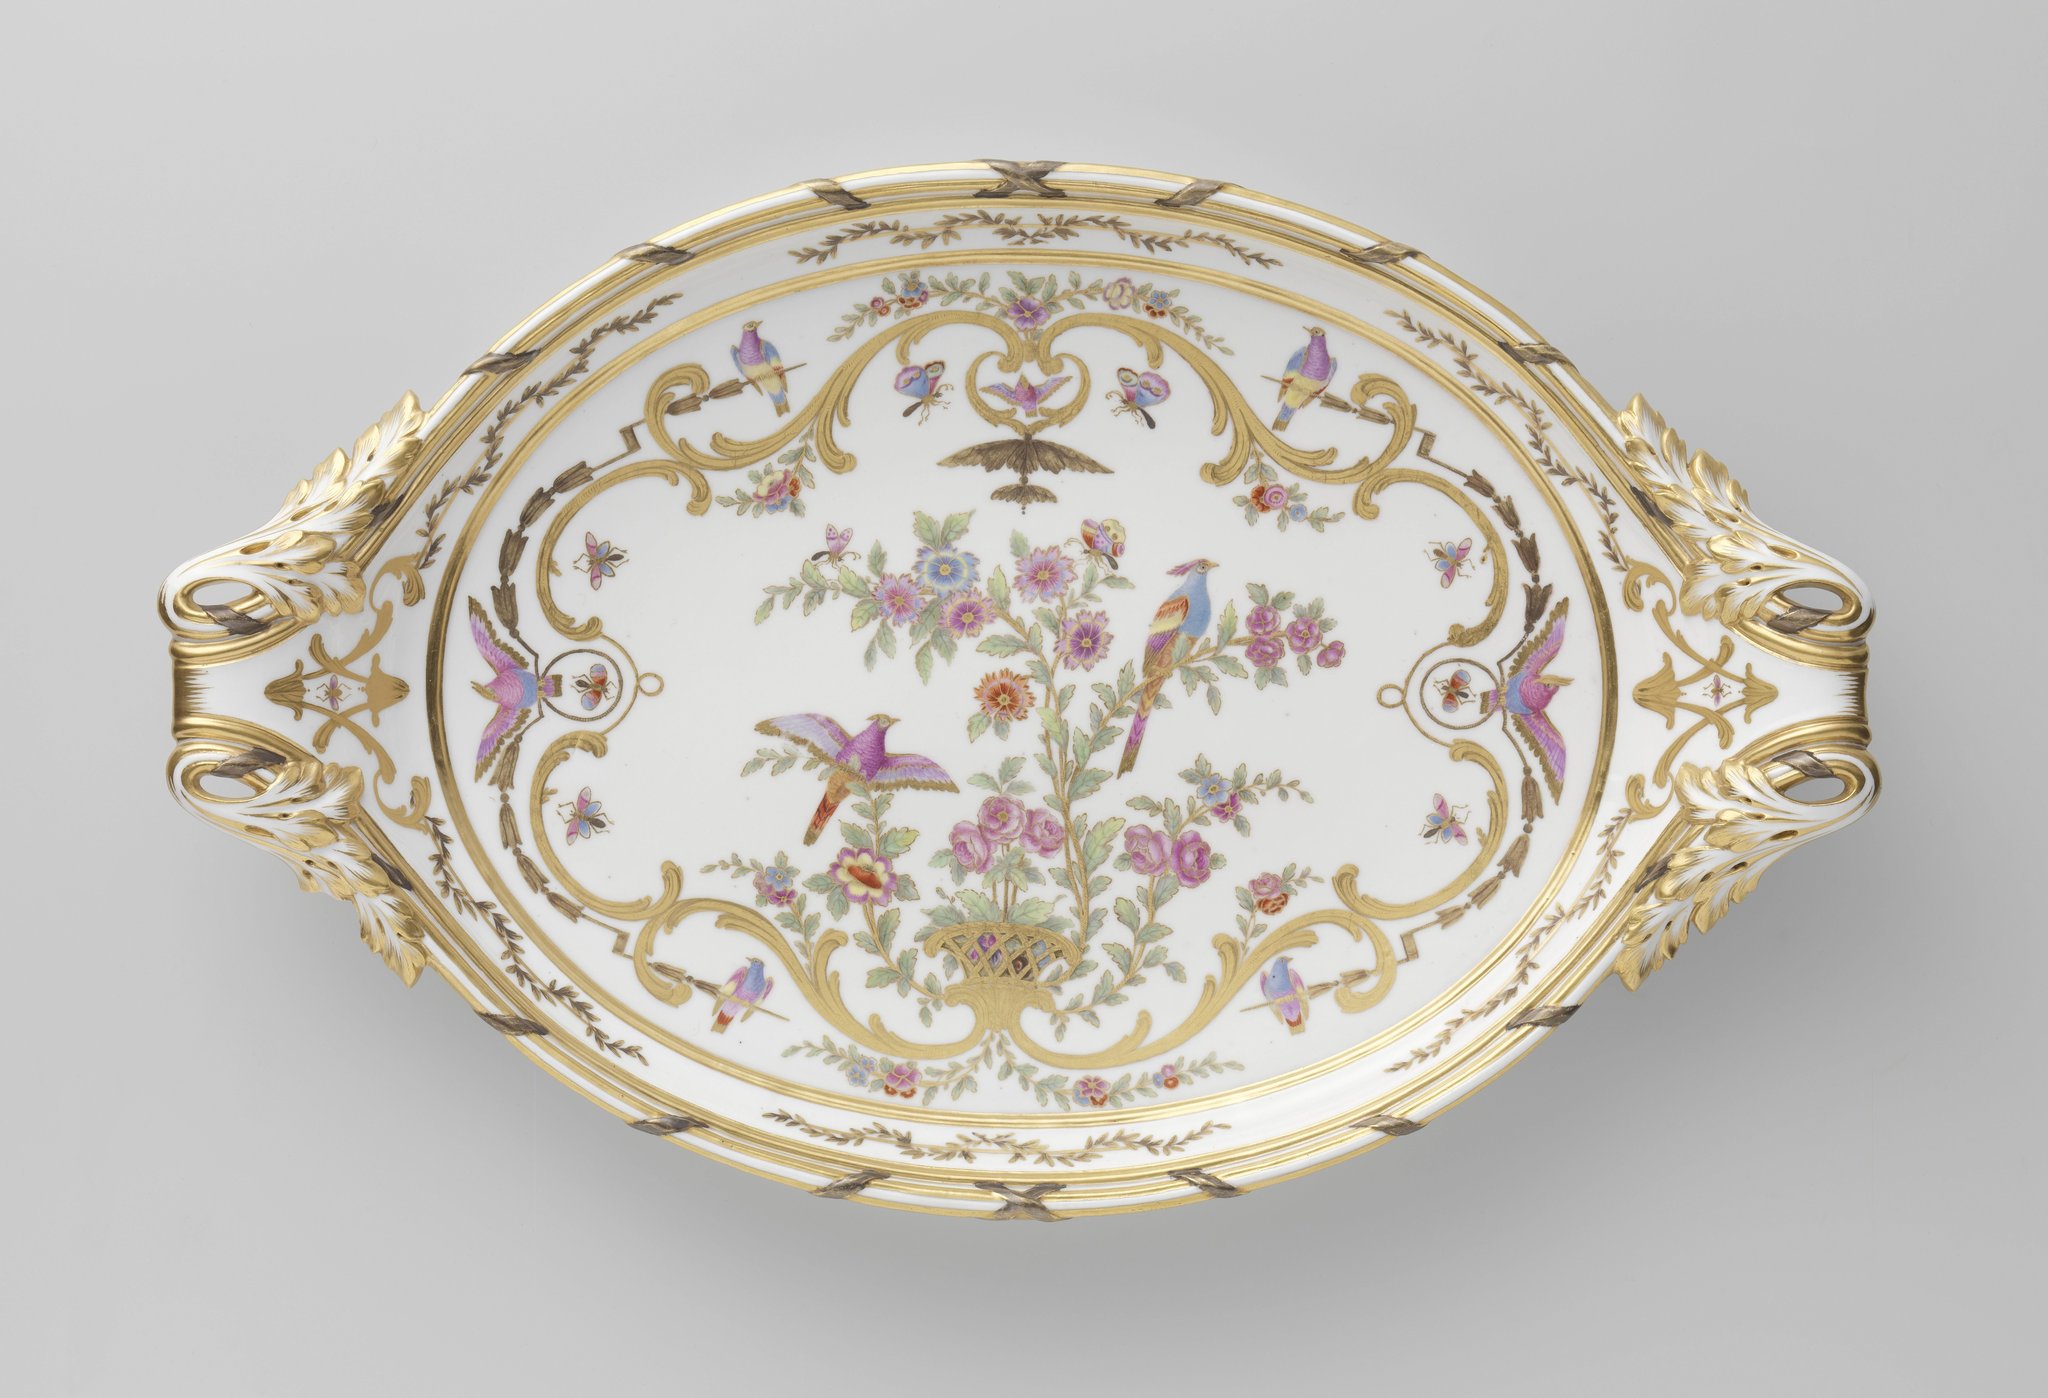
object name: dienblad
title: Tea service with tray (déjeuner Bolvry)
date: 1779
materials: porcelain, silver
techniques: gilding, painted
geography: sèvres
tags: birds, flowers ~ ornament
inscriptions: painter's mark: ‘F.’, mark: ‘9’, factory mark, mark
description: The Sèvres factory succeeded in making true hard-paste porcelain containing kaolin (white clay) only in 1769. Many new patterns were developed for this kind of porcelain. The painted decoration of this service was influenced by patterned calico fabric (chintz) from India and by enamel from China.